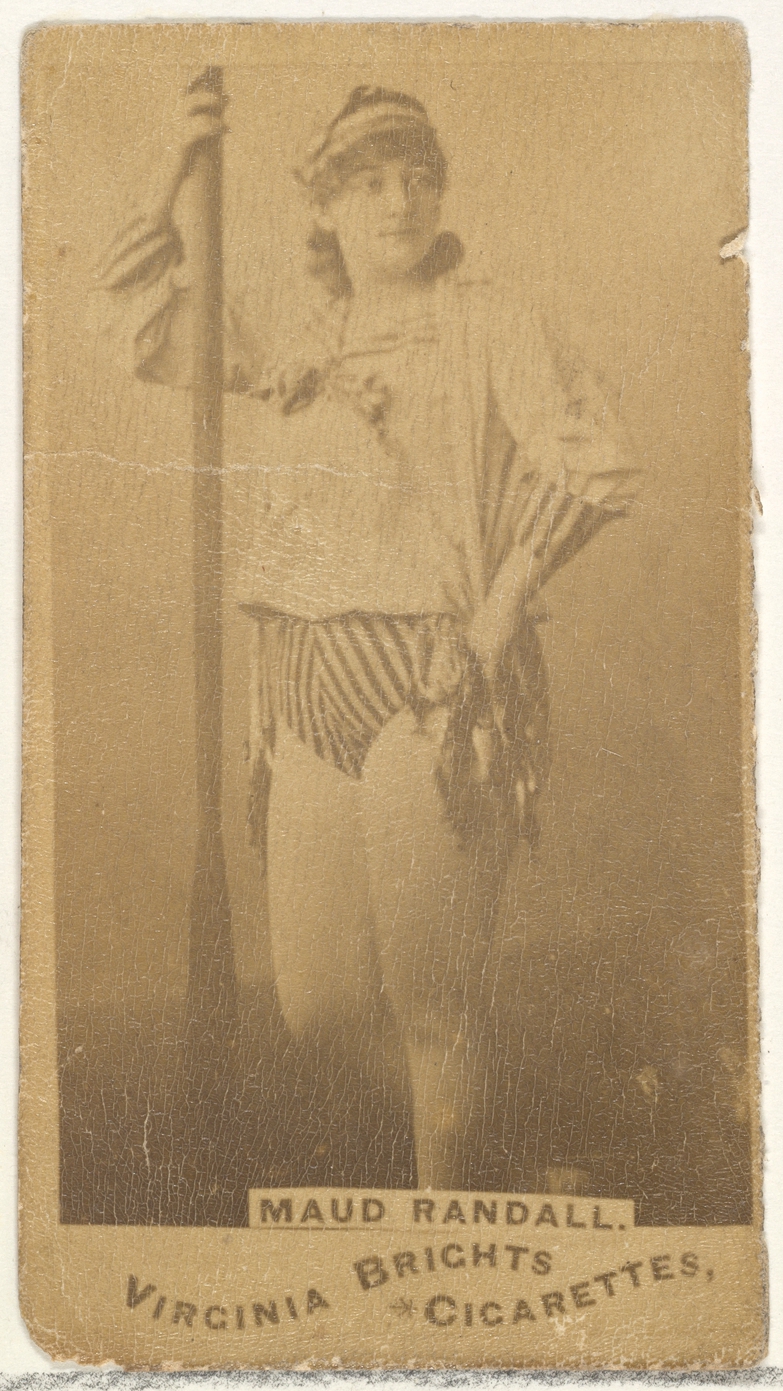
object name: photograph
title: Maud Randall, from the Actors and Actresses series (N45, Type 1) for Virginia Brights Cigarettes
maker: allen & ginter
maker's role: publisher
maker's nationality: american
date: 1888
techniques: albumen silver print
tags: portraits,women,actresses